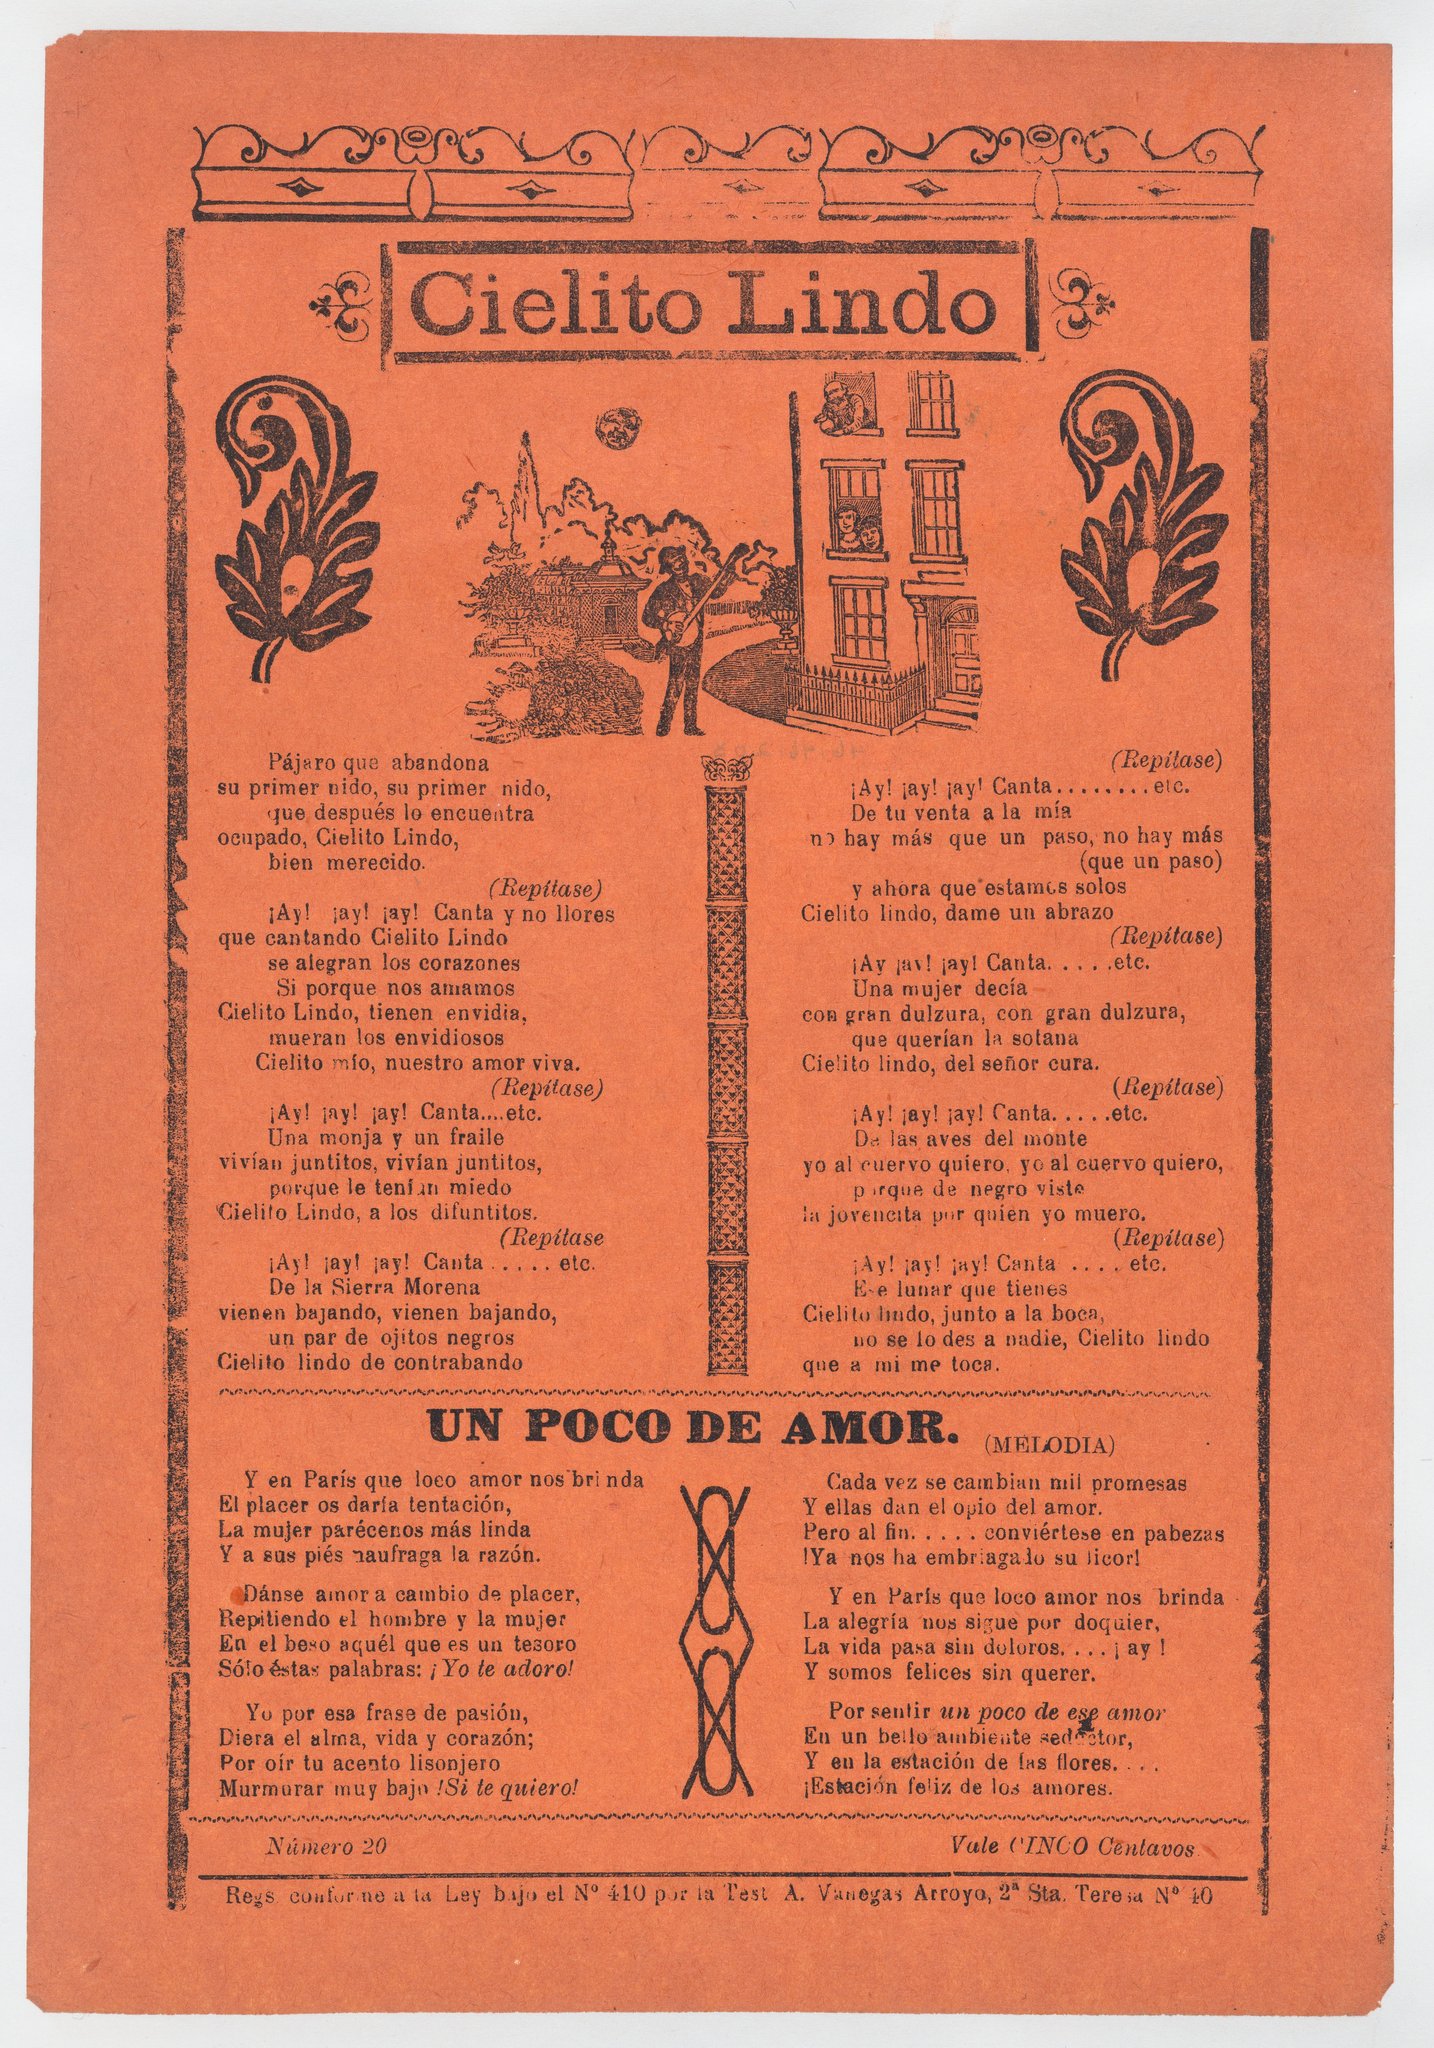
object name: print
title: Broadsheet with love songs, a man playing an instrument and singing outside his lovers' window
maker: josé guadalupe posada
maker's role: artist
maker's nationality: mexican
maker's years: 1852-1913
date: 1900-1913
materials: paper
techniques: letterpress, lithography